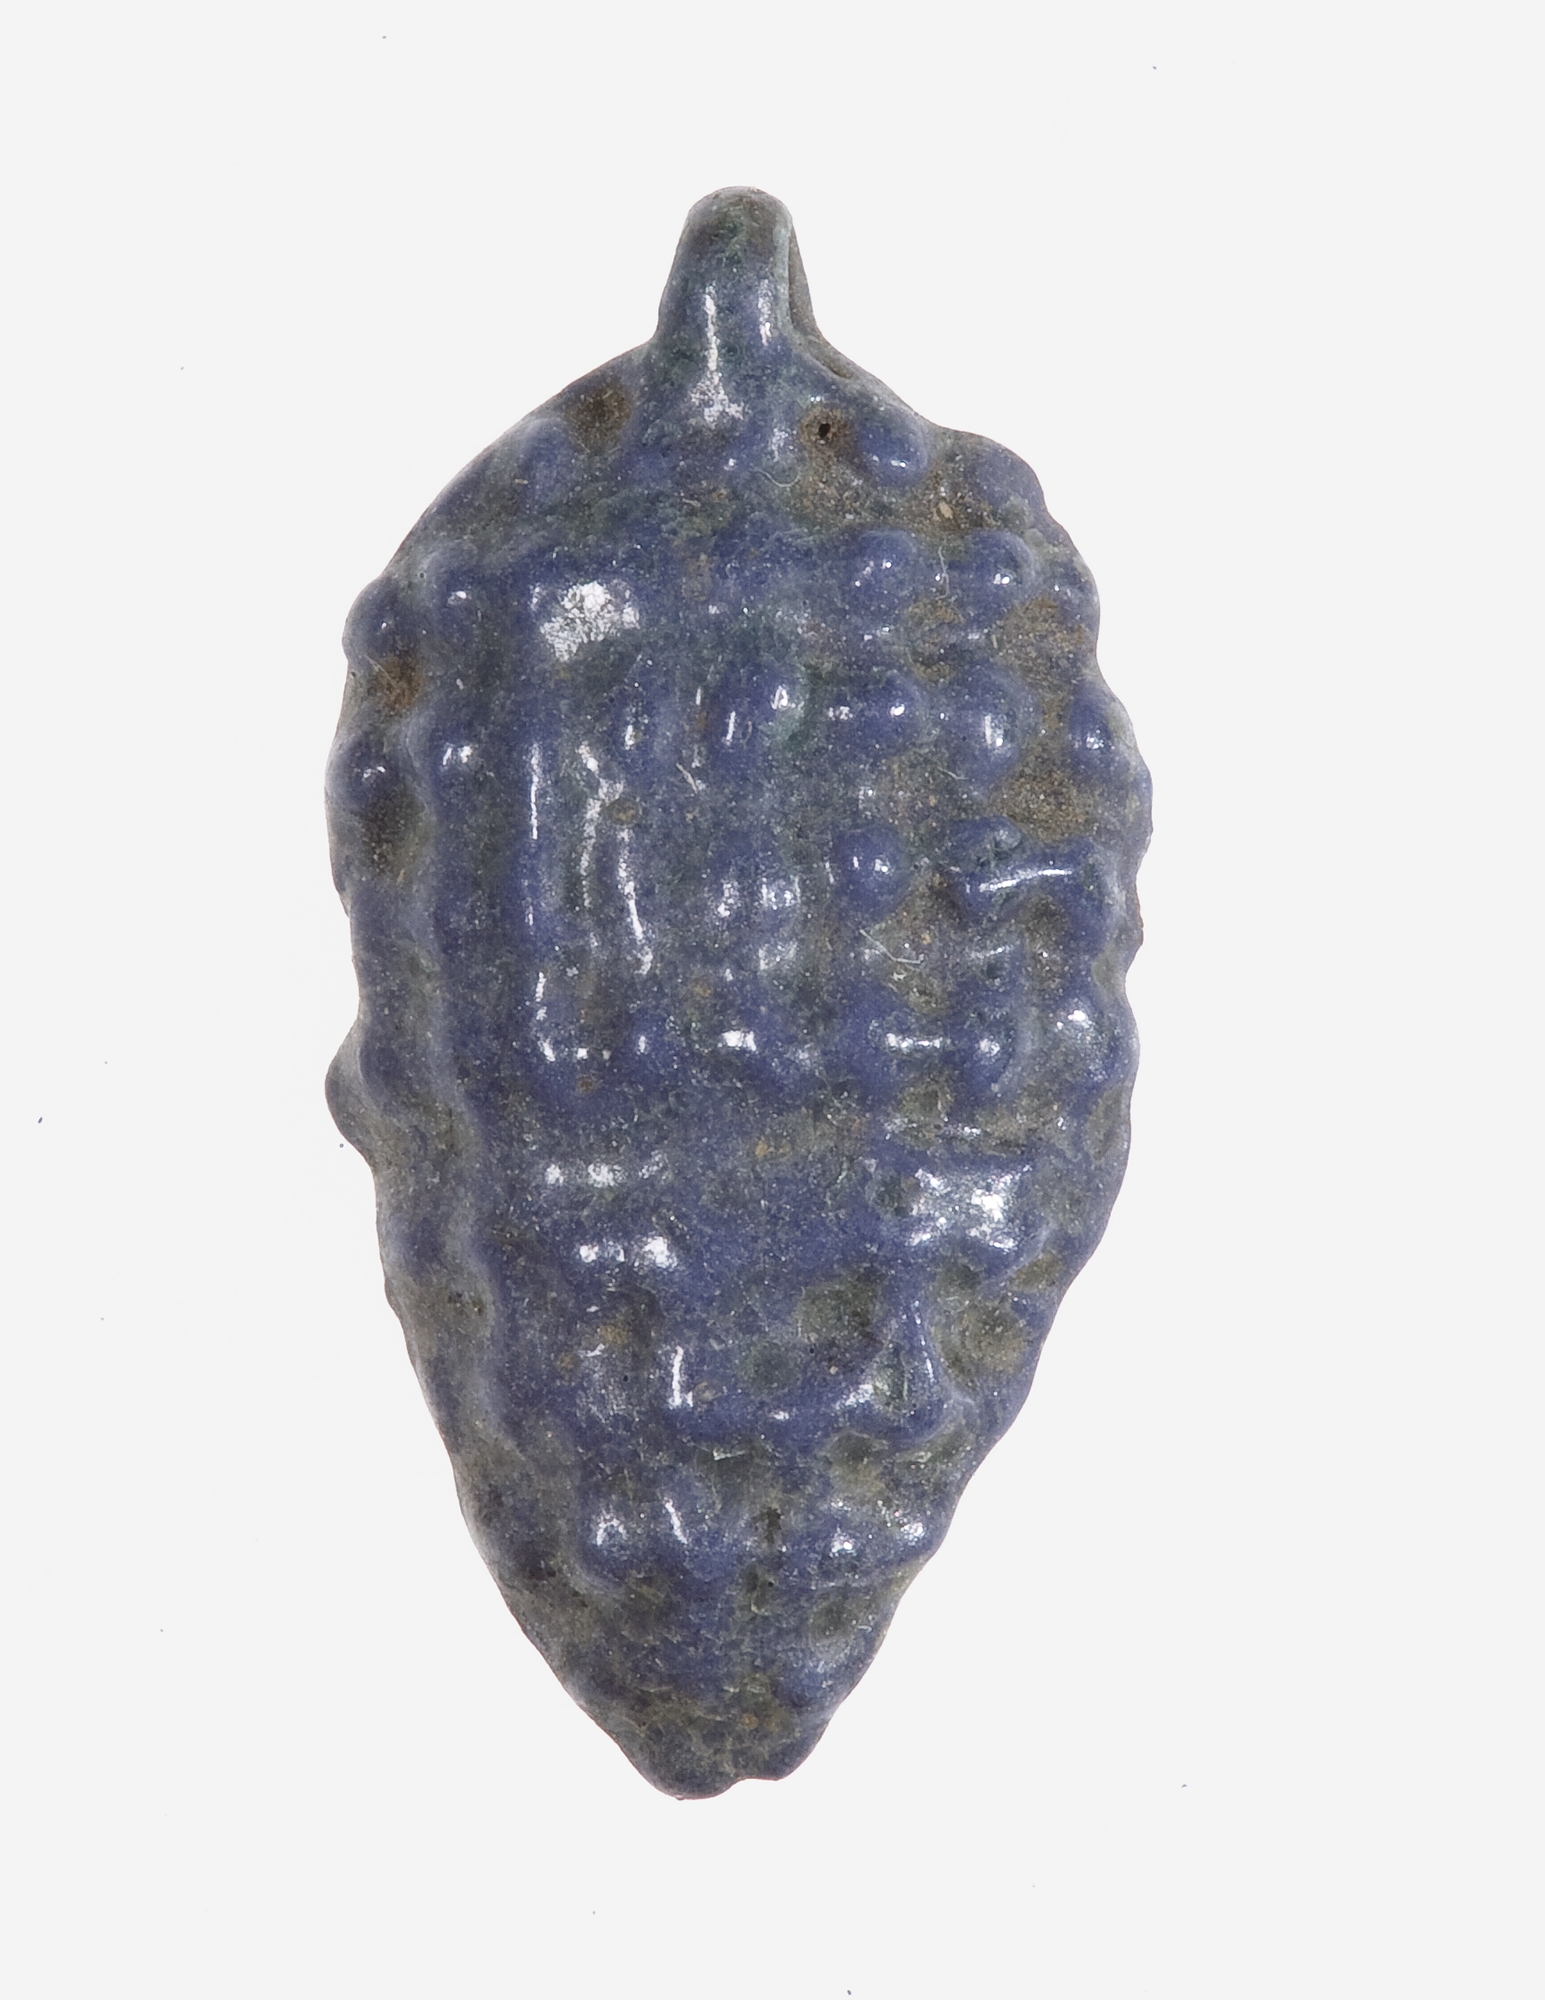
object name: pendant, grape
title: Pendant: Bunch of Grapes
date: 1390-1352 BCE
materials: faience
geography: egypt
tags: grapes